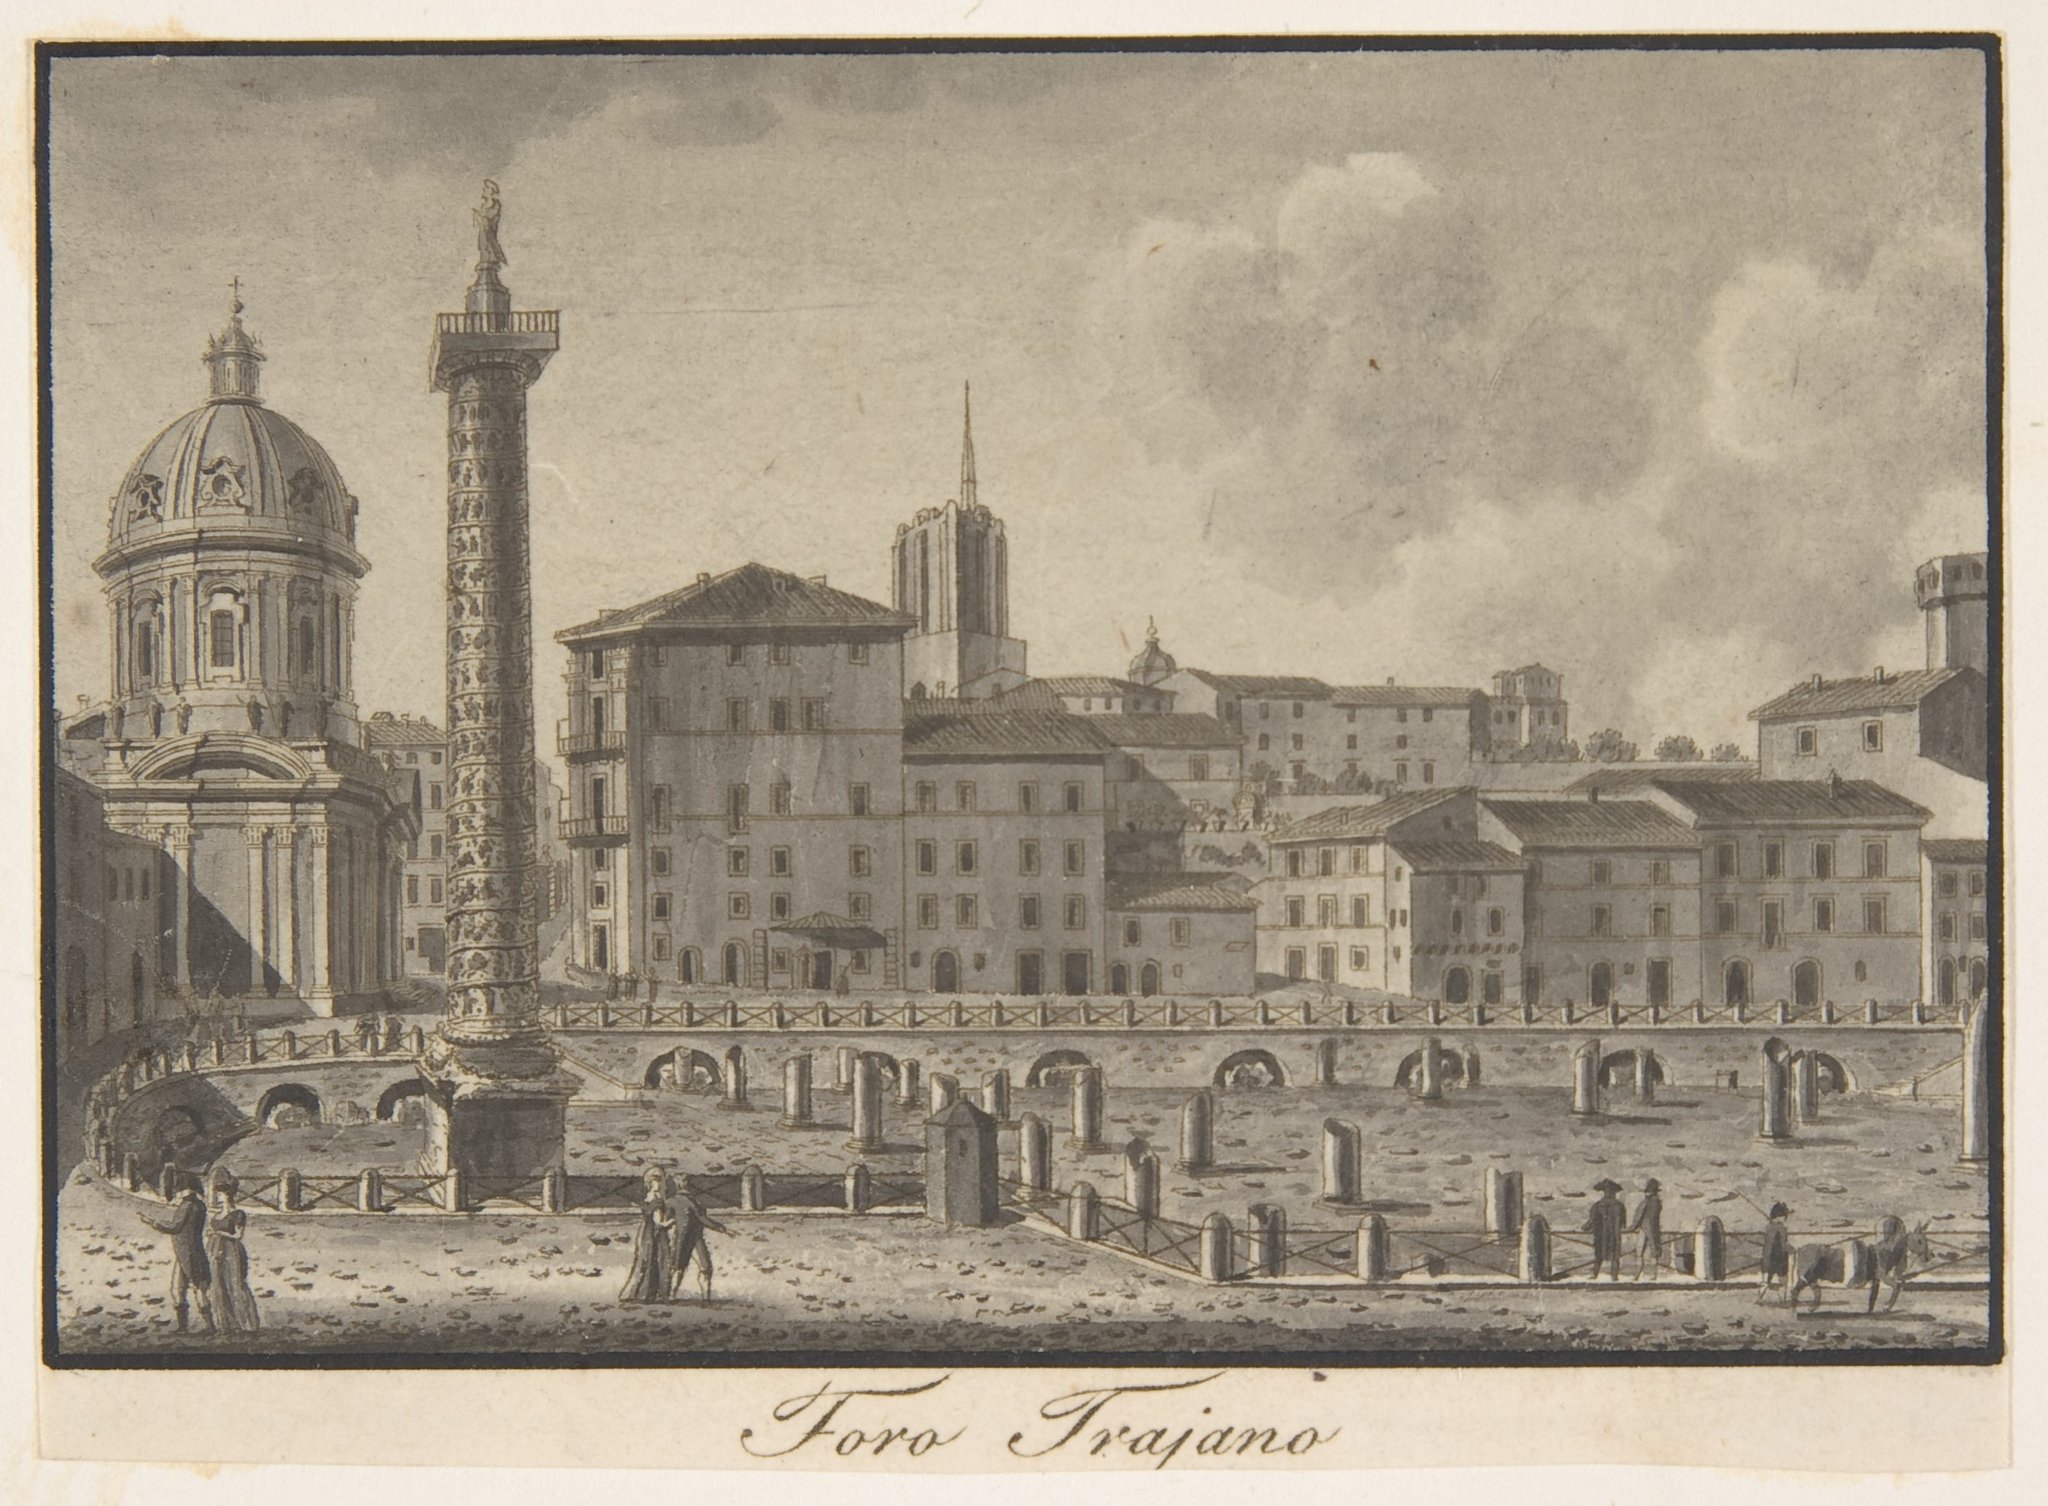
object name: drawing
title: The Forum of Trajan, Rome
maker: giovanni battista cipriani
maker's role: artist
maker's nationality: italian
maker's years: 1766-1839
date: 1767-1866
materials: ink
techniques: drawing, pen, wash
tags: monuments,men,women,rome